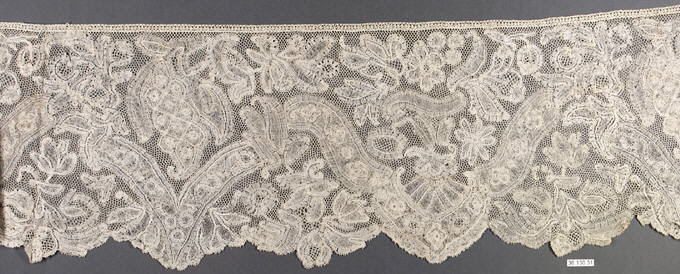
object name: border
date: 1701-1800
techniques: lace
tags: flowers